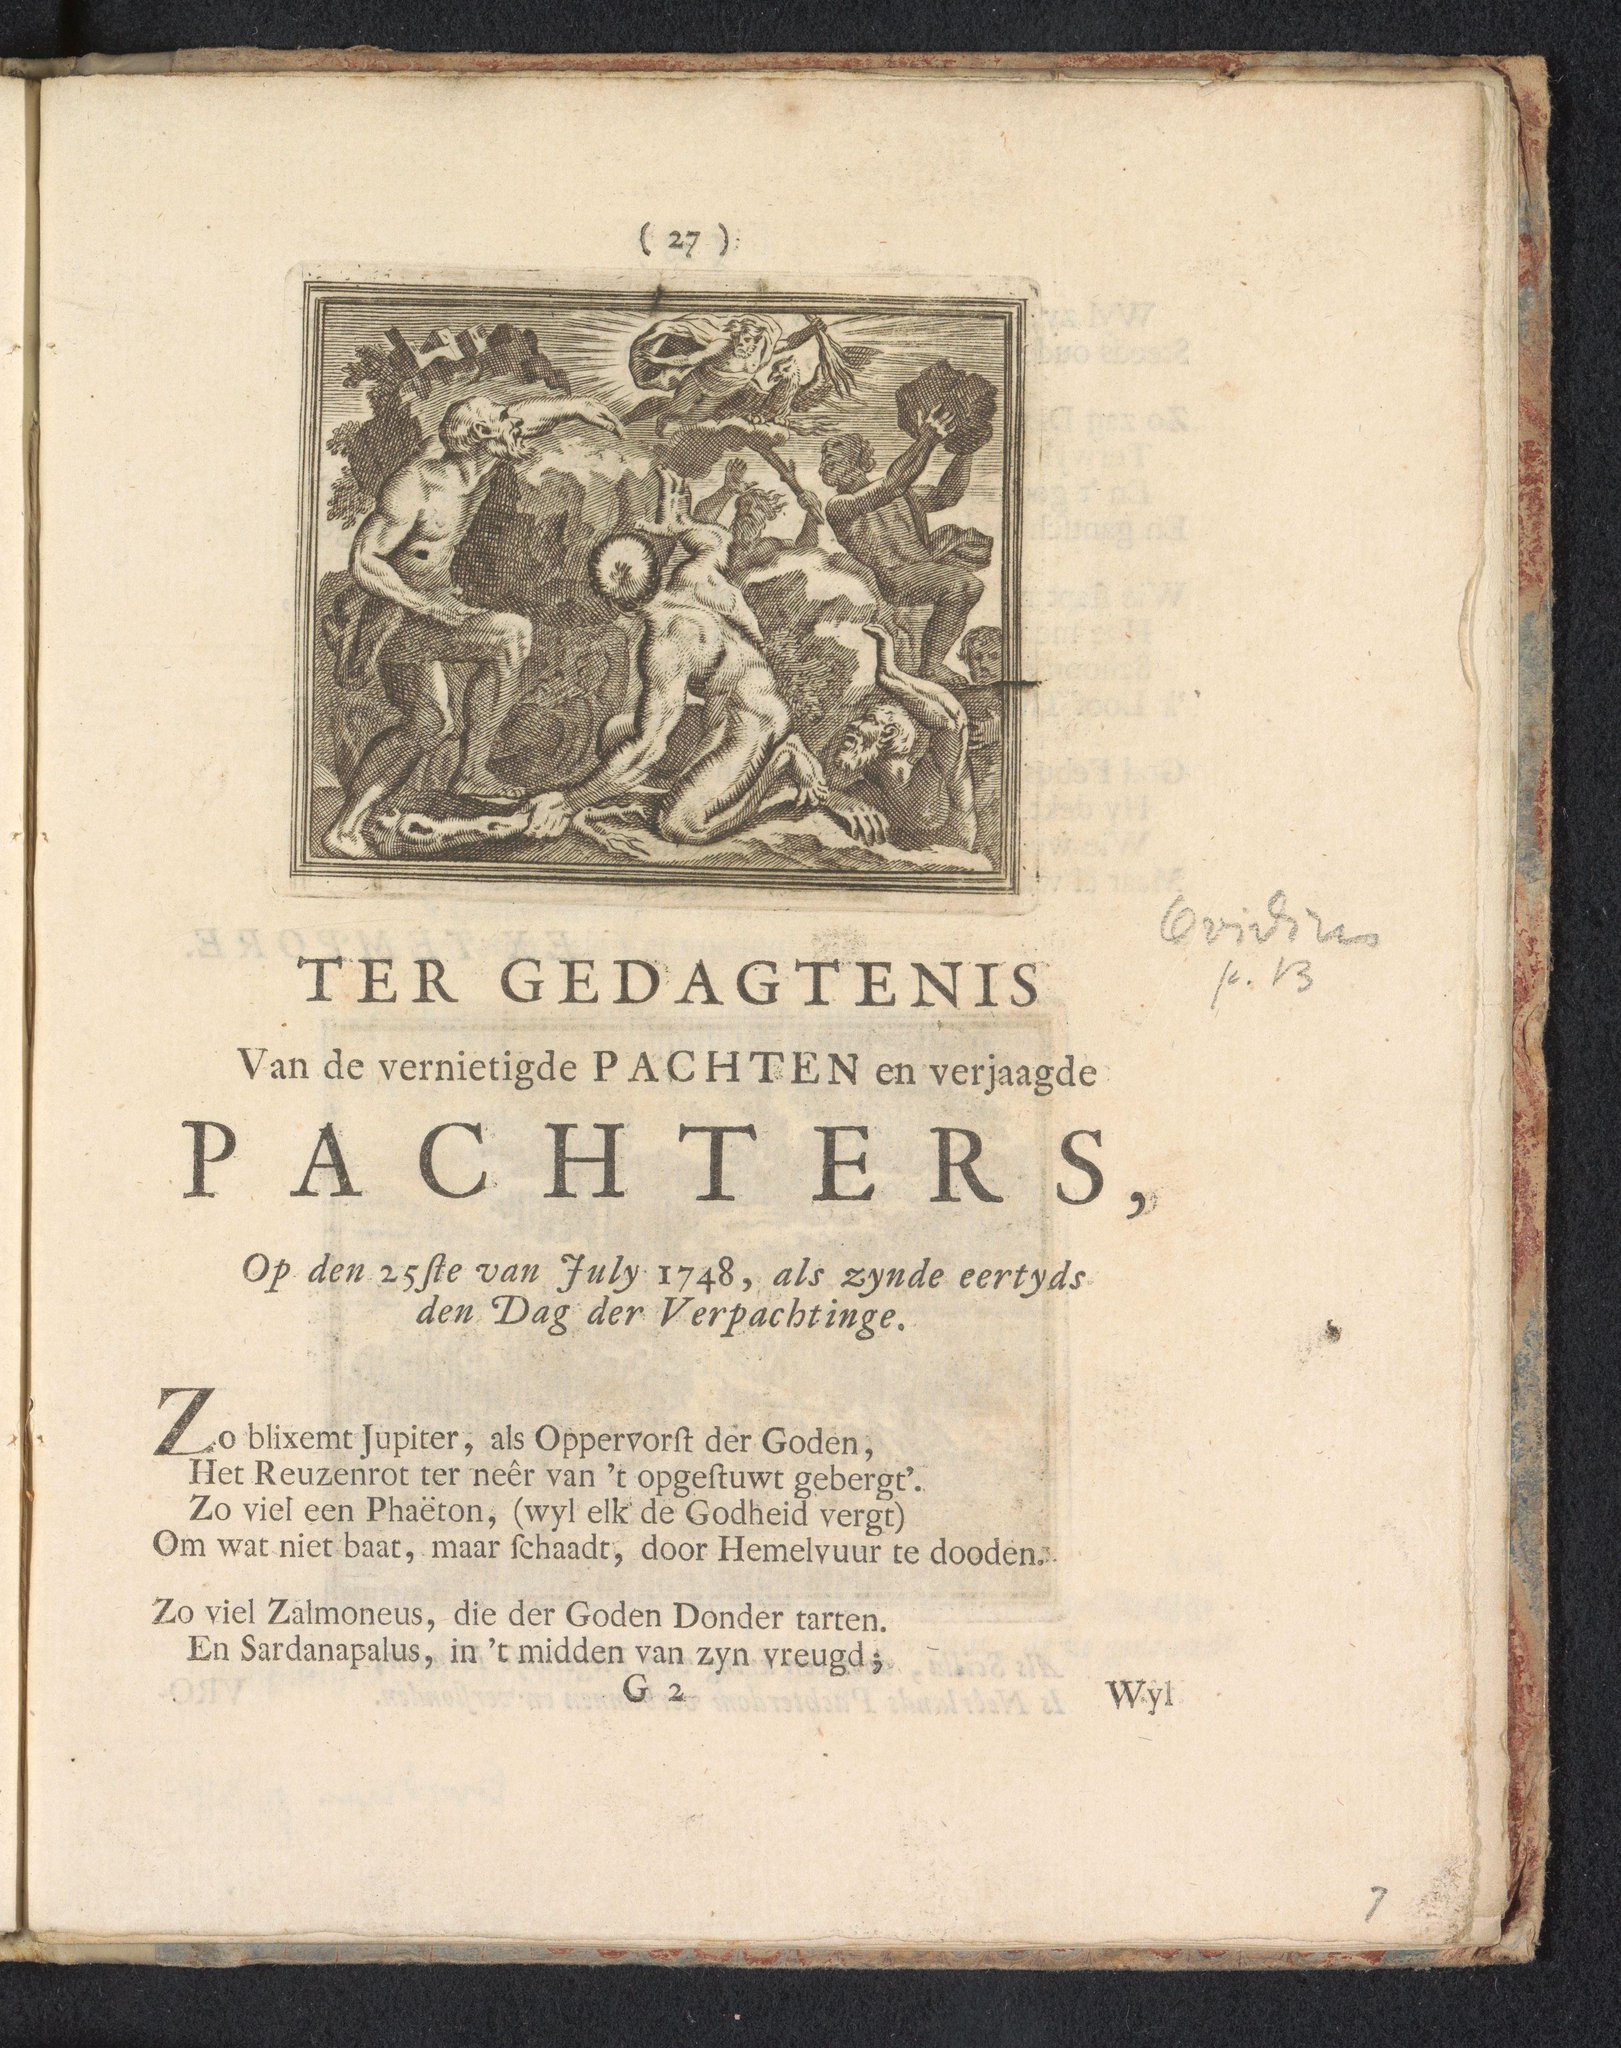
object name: print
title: Opstand der Titanen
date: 1748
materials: paper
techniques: engraving, letterpress printing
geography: harderwijk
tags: war of the titans against jupiter and allies: titanomachy, amsterdam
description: Opstand van de Titanen tegen Jupiter. llustratie bij het vers: Ter Gedachtenis van de vernietigde Pachten en verjaagde Pachters, op den 25ste van July 1748, op p. 27, onderdeel van: Den Bedroefden Pachter door Jan Weetal over de Pachtersoproer in 1748.